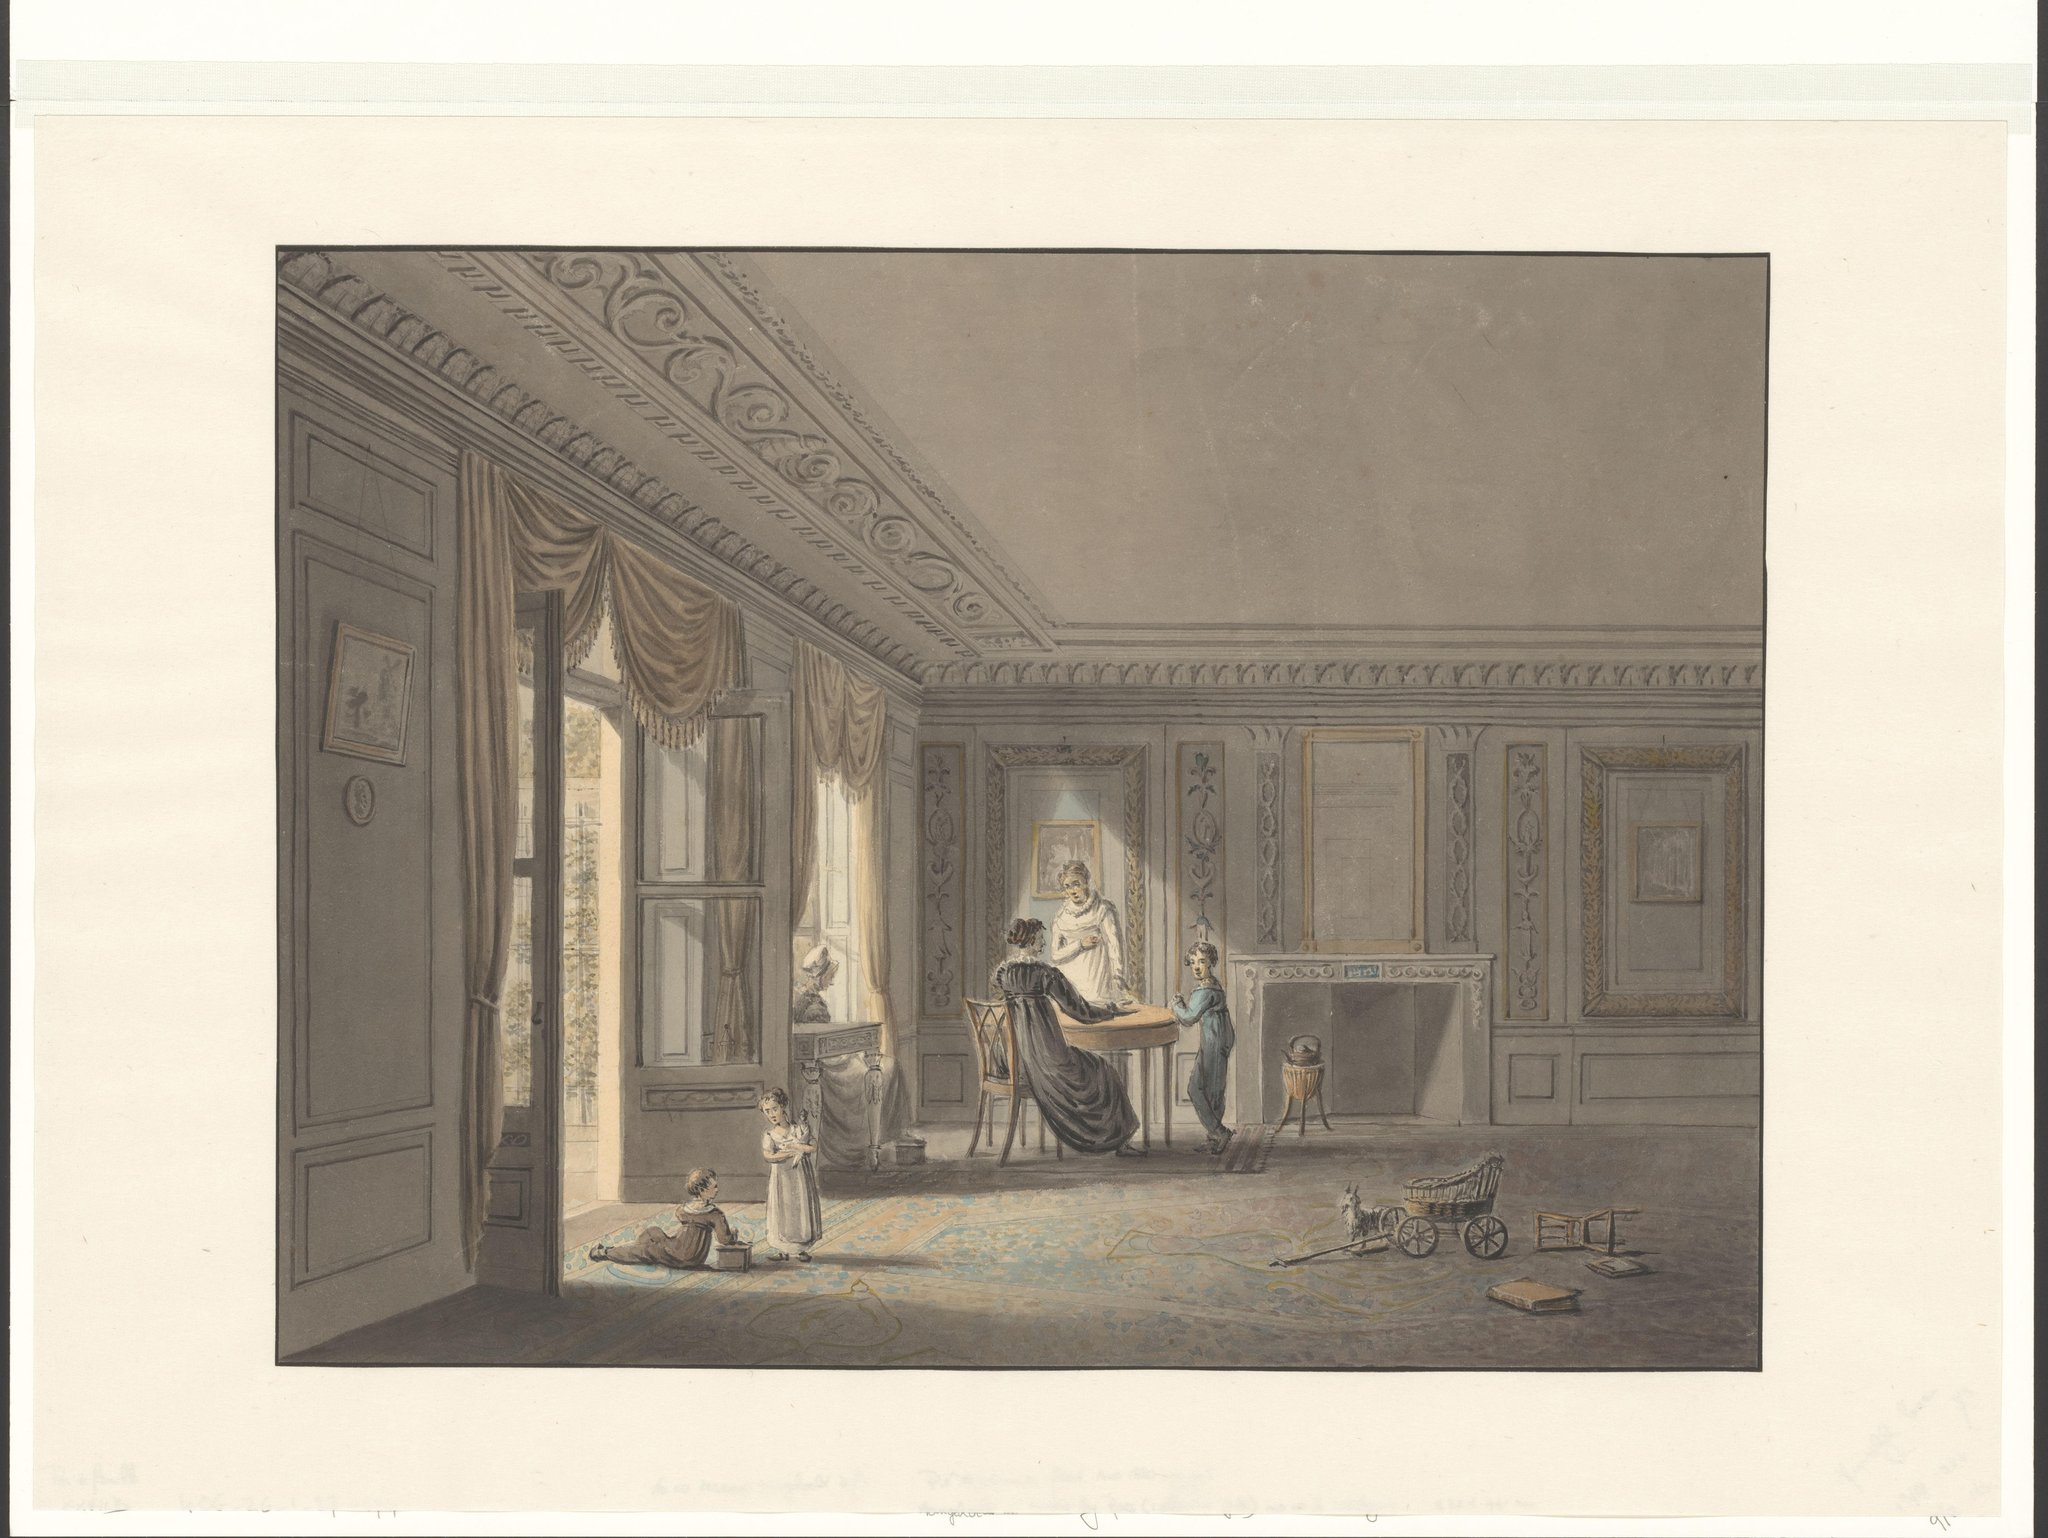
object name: drawing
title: Huiselijk interieur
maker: pieter nicolaas arntzenius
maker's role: draughtsman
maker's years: 1802-1857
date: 1820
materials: paper, watercolor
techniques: brush, pen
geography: netherlands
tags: mother with son(s) and daughter(s) (mother-love), communal rooms, family life at home